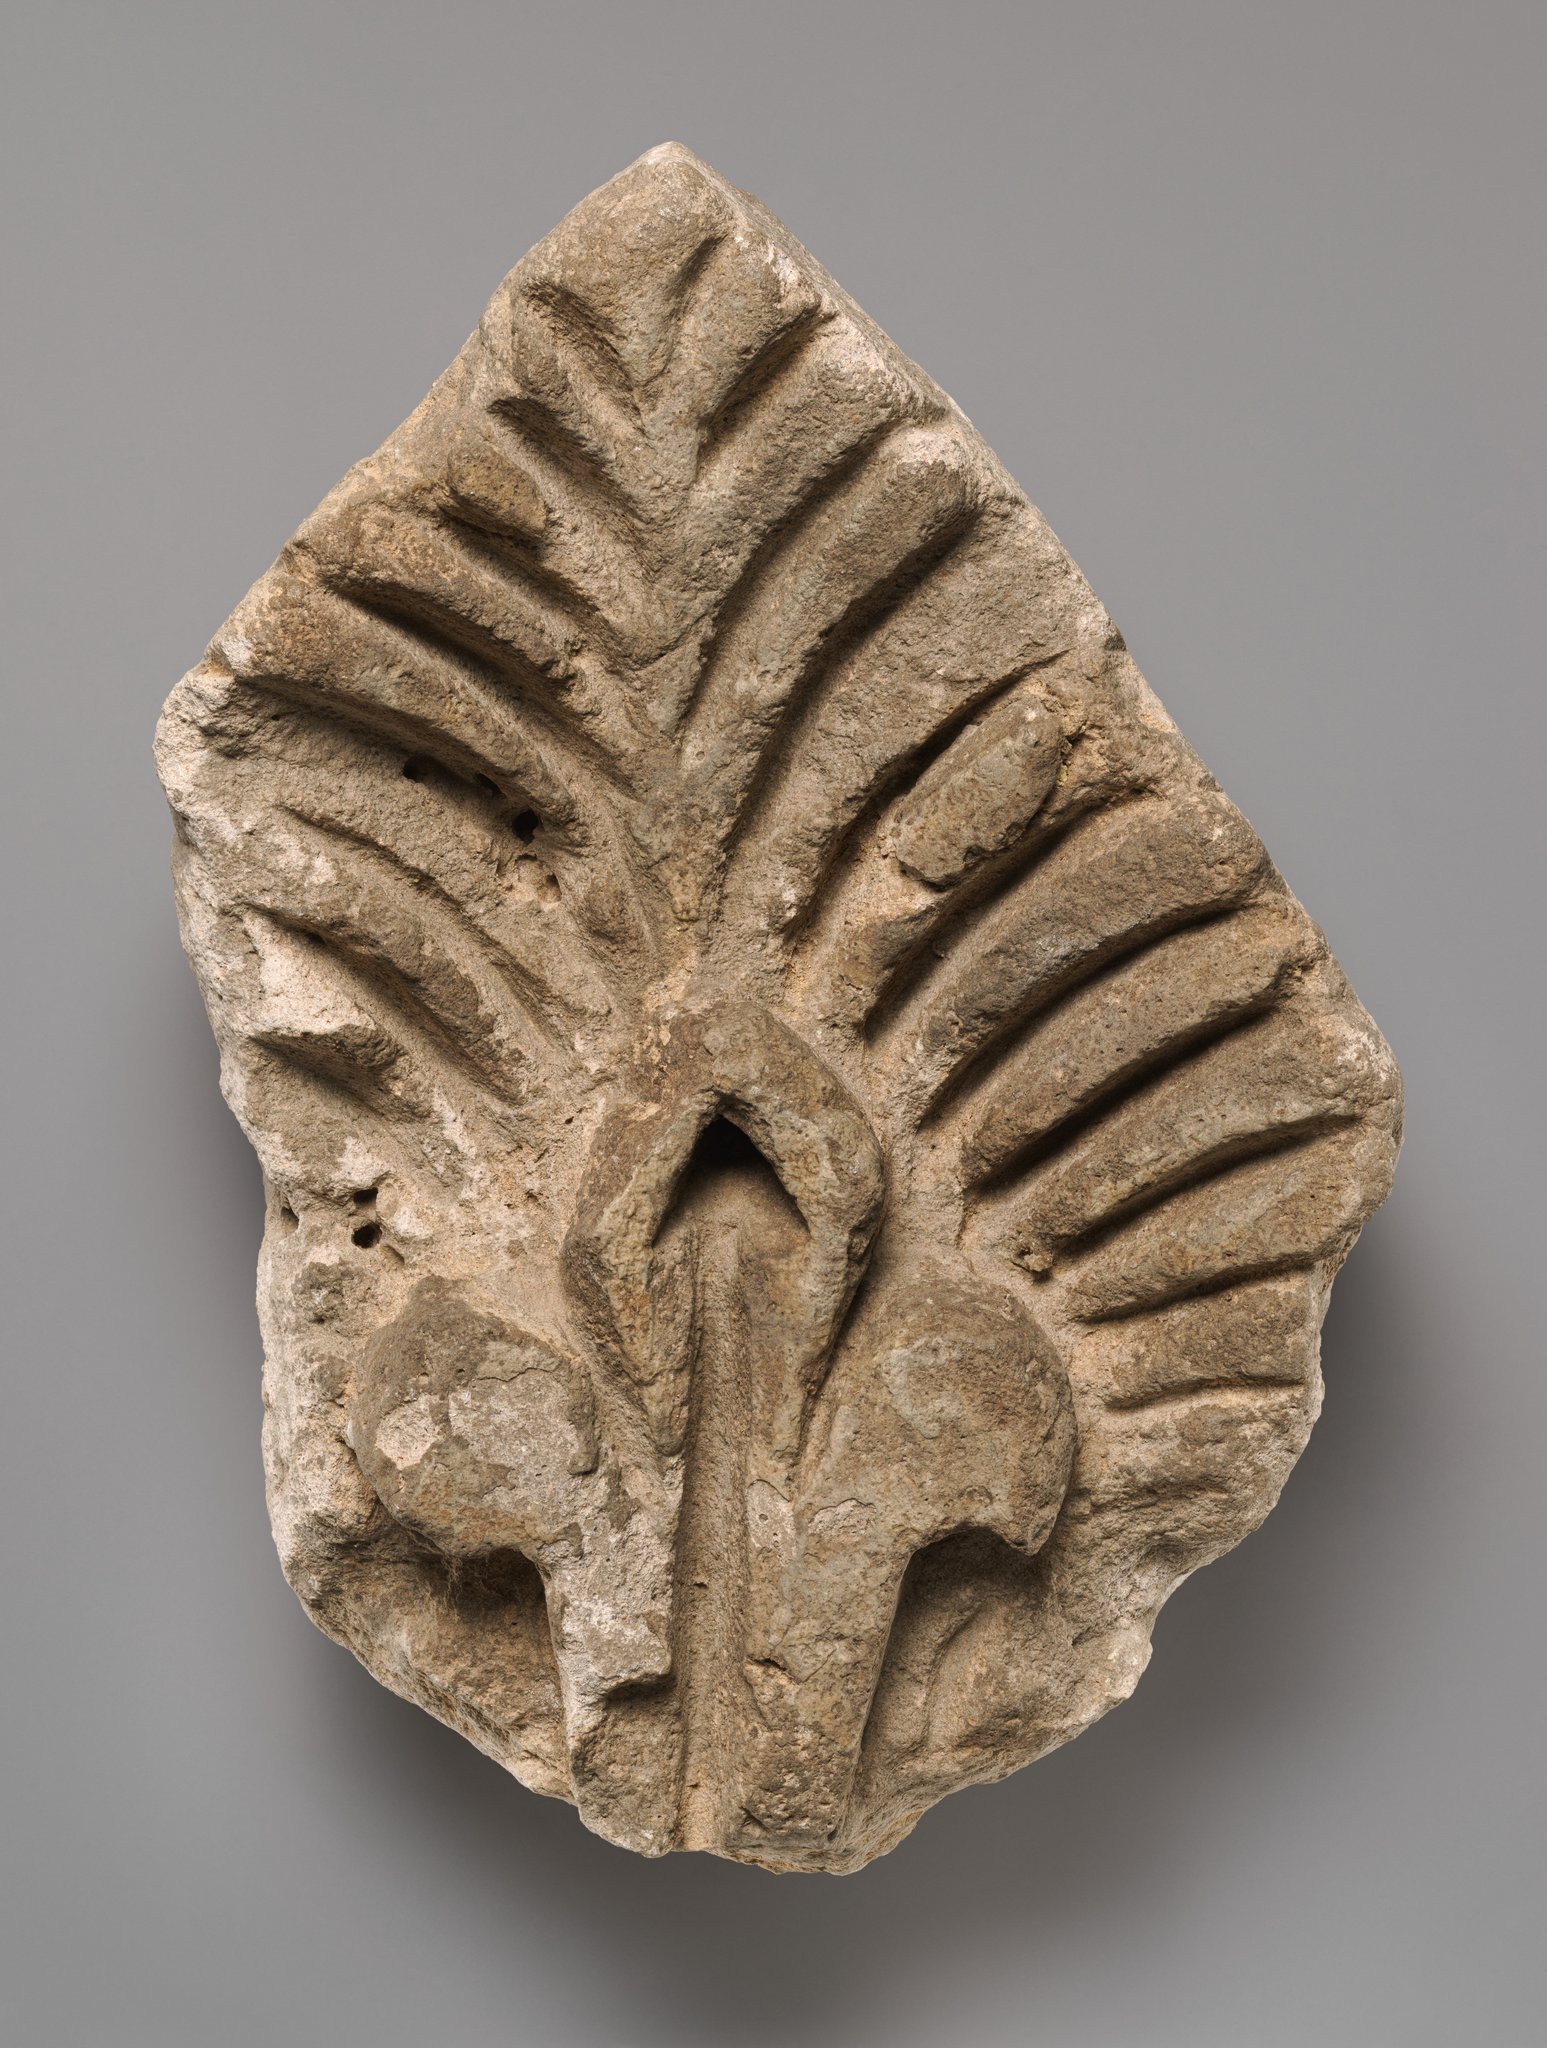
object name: relief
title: Relief fragment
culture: sasanian or islamic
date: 501-800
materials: plaster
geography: mesopotamia